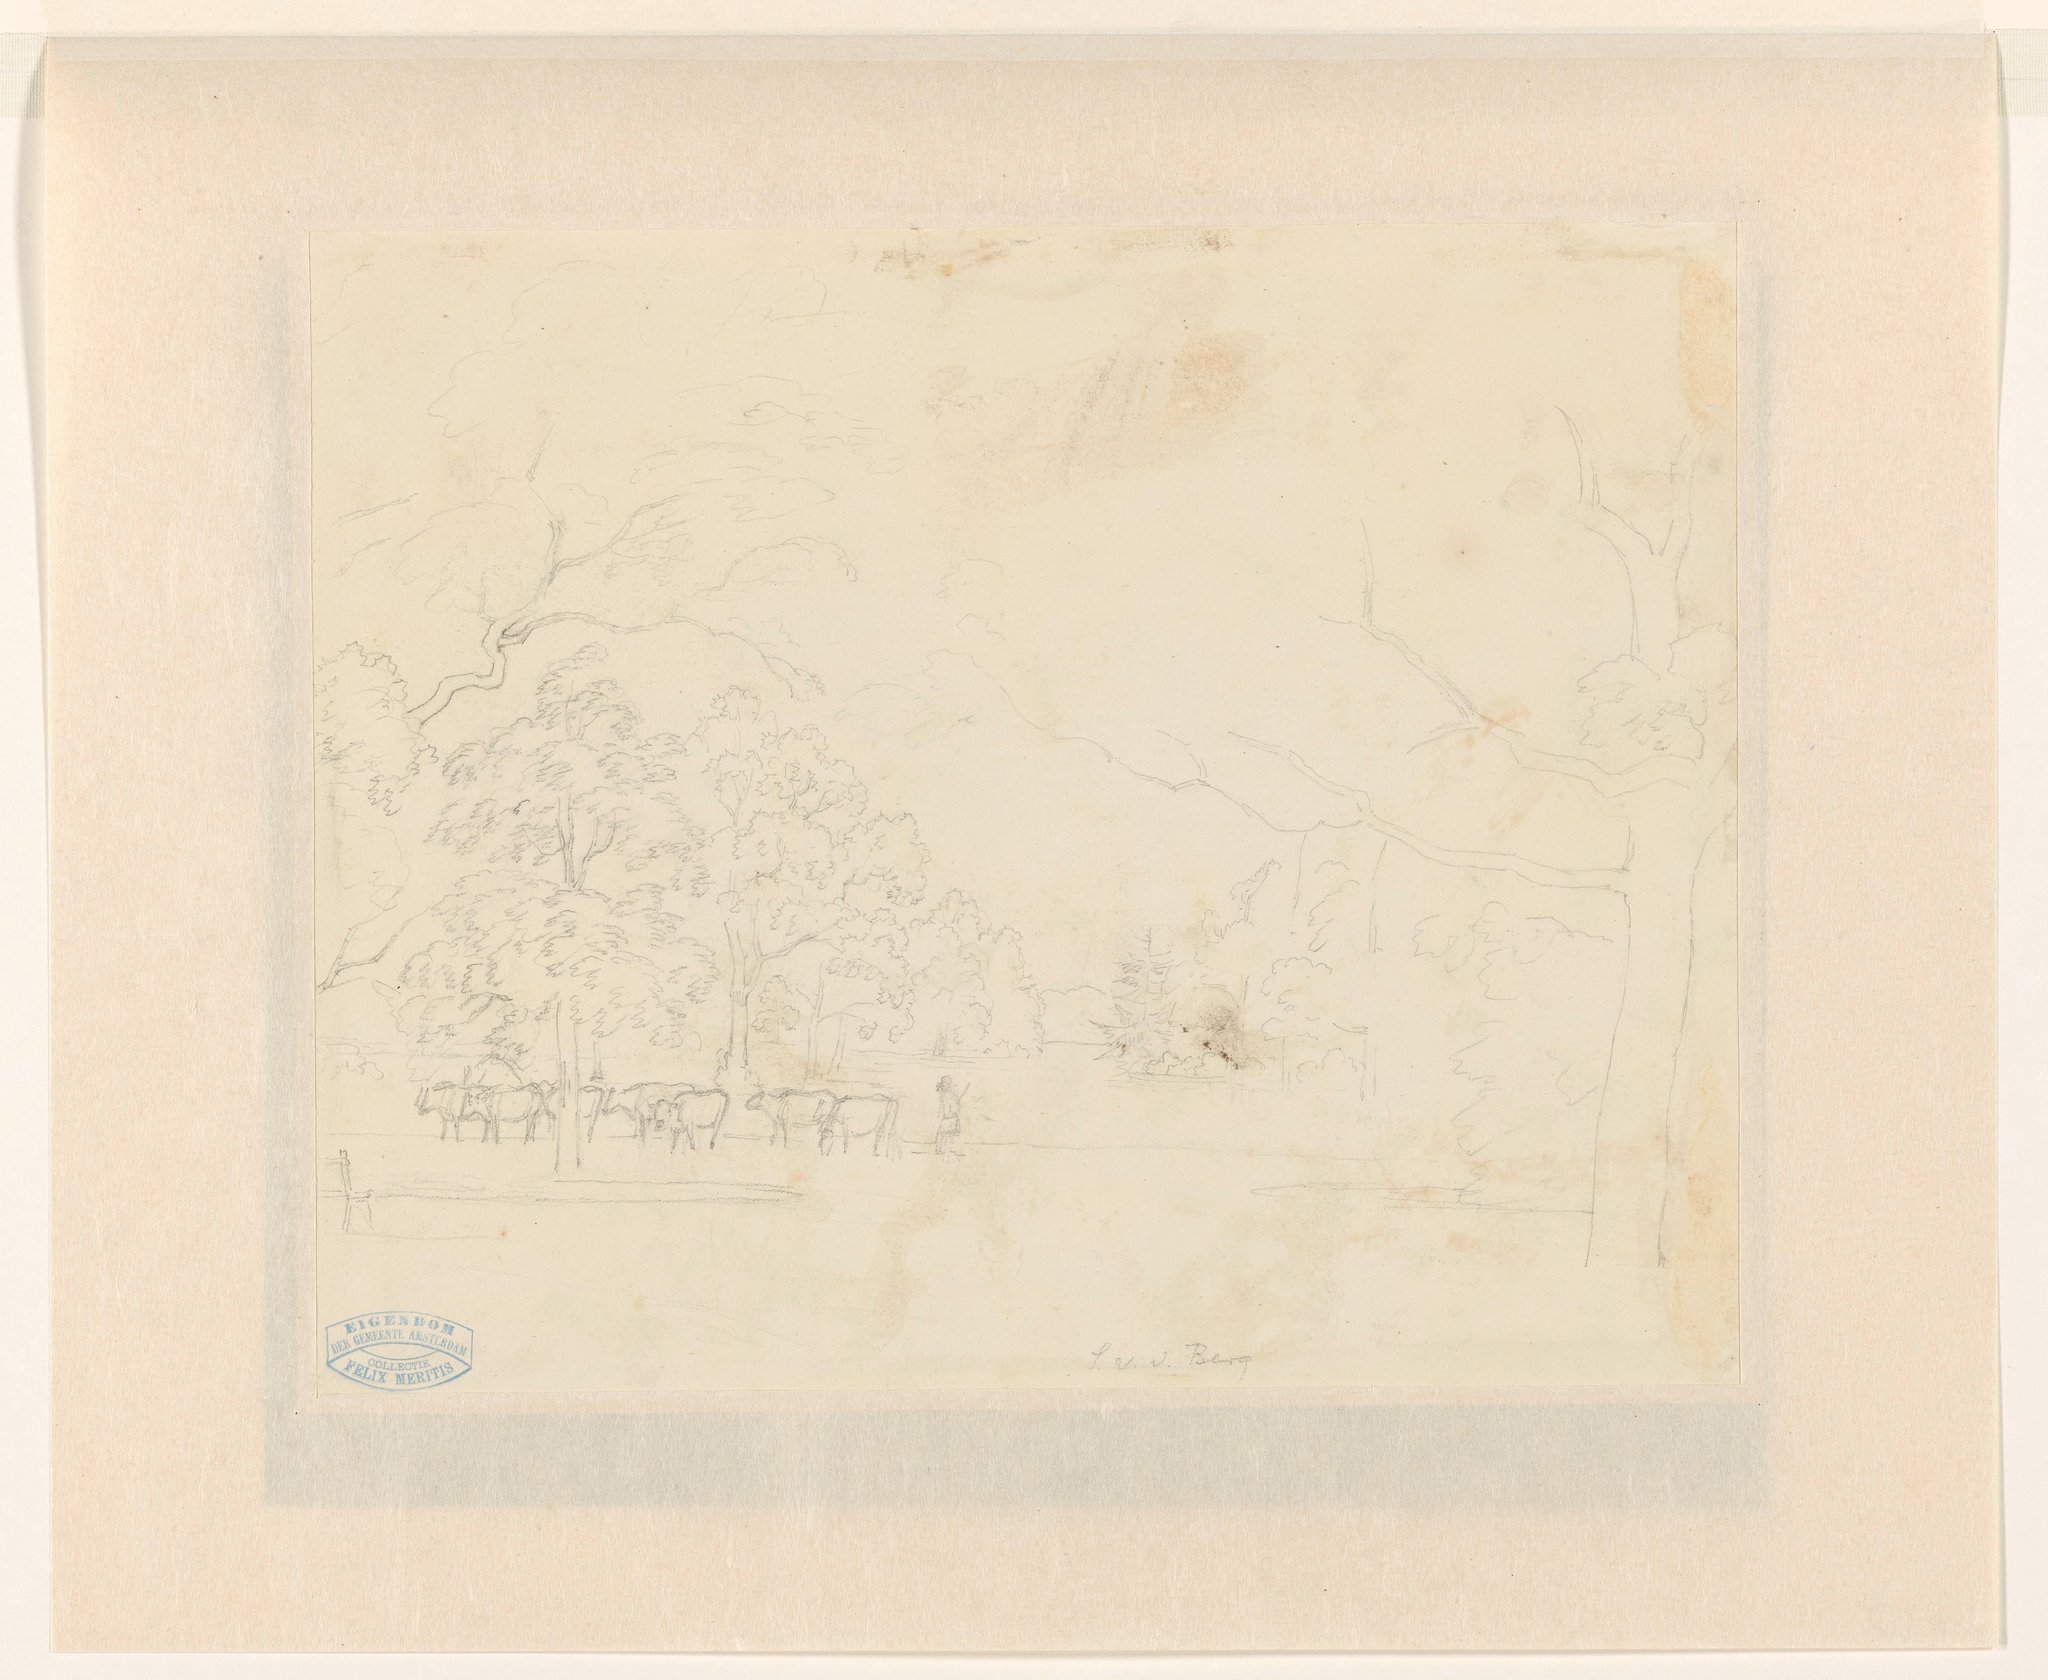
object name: drawing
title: Schets van een landschap met veehoeder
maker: simon van den berg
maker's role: draughtsman, print maker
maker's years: 1812-1891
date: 1822-1891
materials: paper, pencil